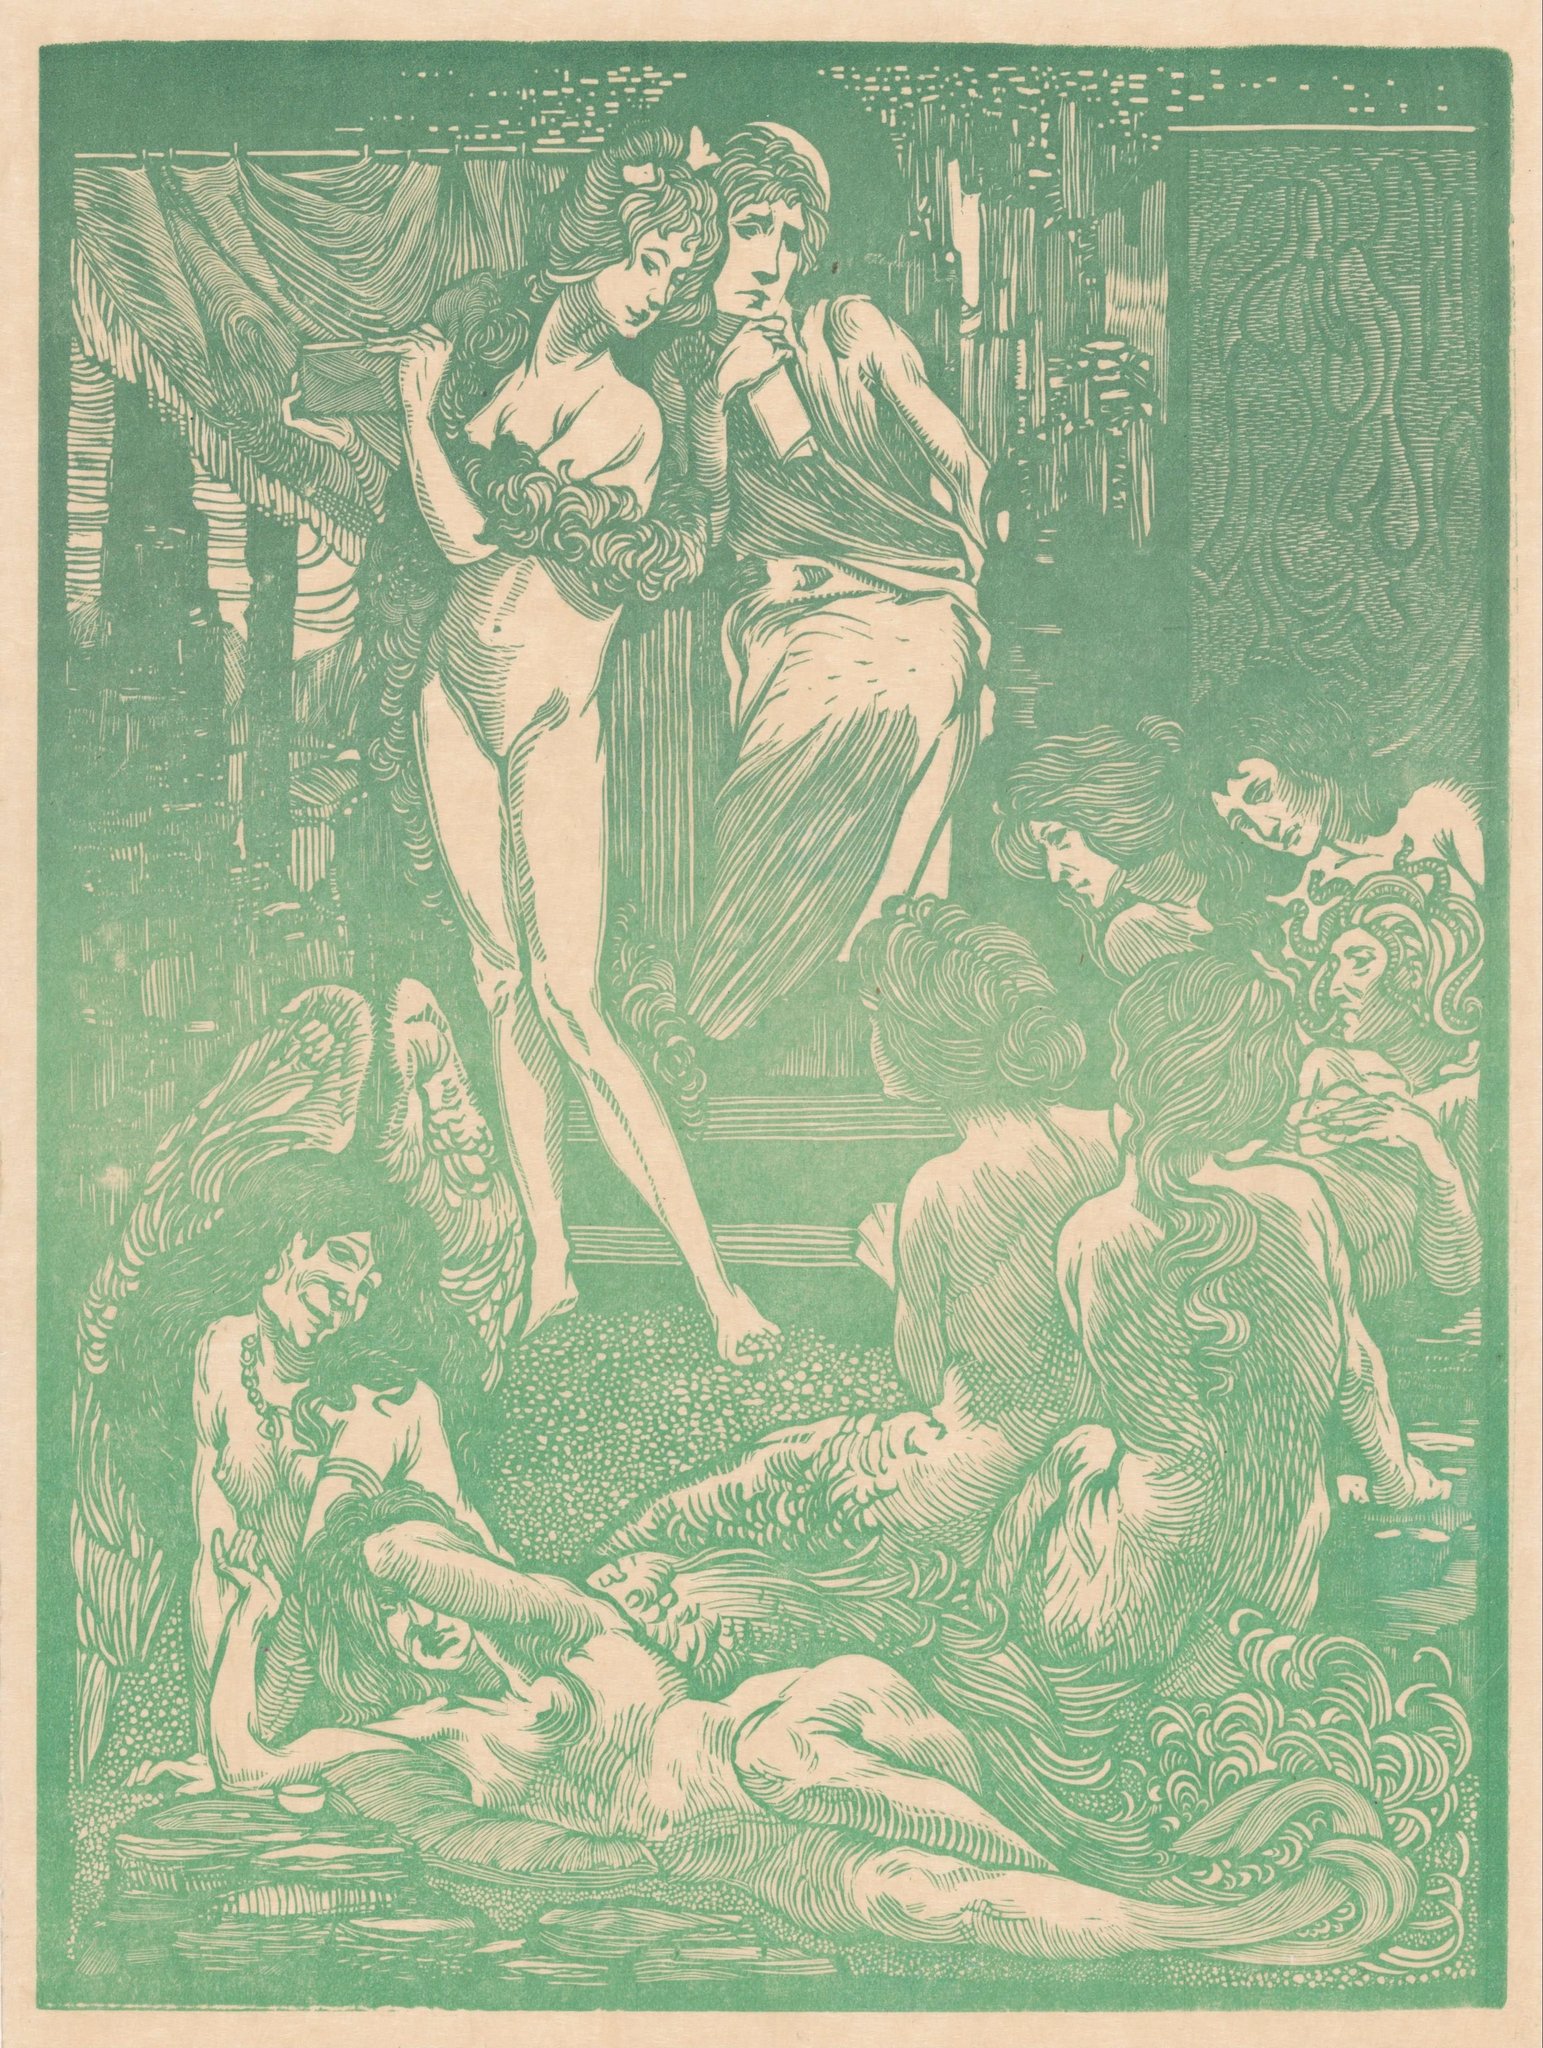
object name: print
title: Negen fantastische vrouwenfiguren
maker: johannes josephus aarts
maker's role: draughtsman, print maker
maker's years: 1871-1934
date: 1897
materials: paper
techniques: woodcut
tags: gorgons, woman (showing herself) undressed, quasi-nude, fabulous beings with wings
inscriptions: collector's mark: Lugt 2166, collector's mark: Lugt 2228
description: Linksonder een vrouw met vleugels, rechts van het midden een Gorgoon, een vrouw met slangen in plaats van haar. Boven het midden een vrouw op een troon.